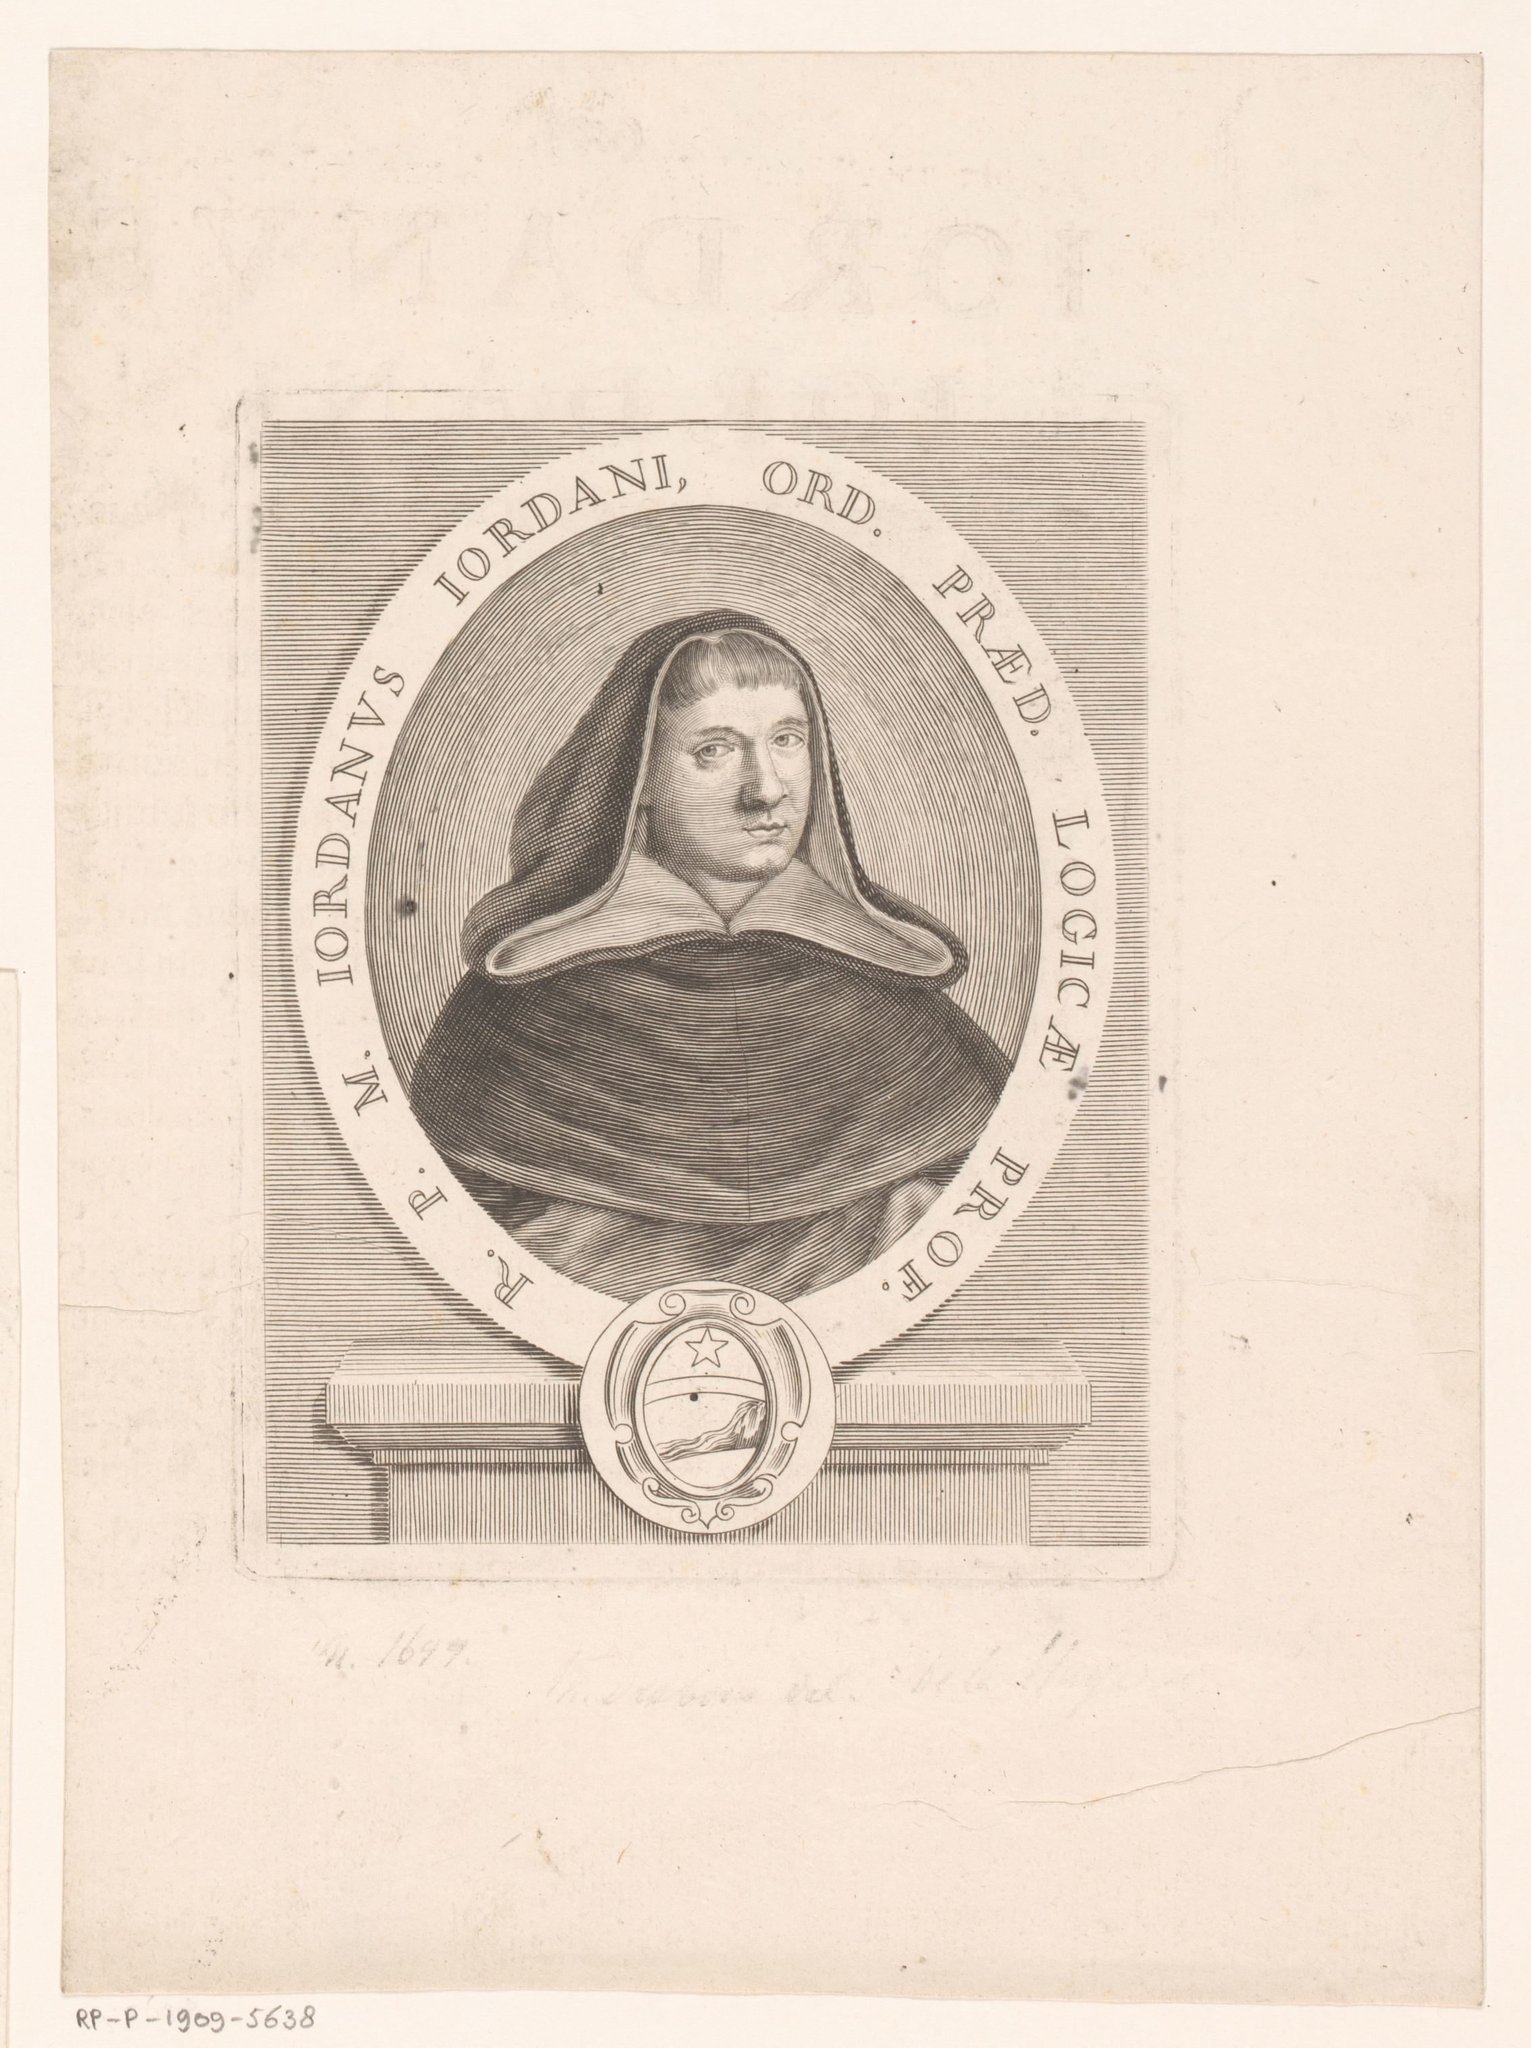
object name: print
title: Portret van Iordanus Iordani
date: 1682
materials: paper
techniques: engraving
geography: padua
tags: historical persons, professor, armorial bearing, heraldry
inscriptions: collector's mark: Lugt 2228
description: Prent uit: Patin, Charles. Lyceum Patavinum: sive icones et vitae professorum. Padua: Frambotti, Petri Mariae, 1682.